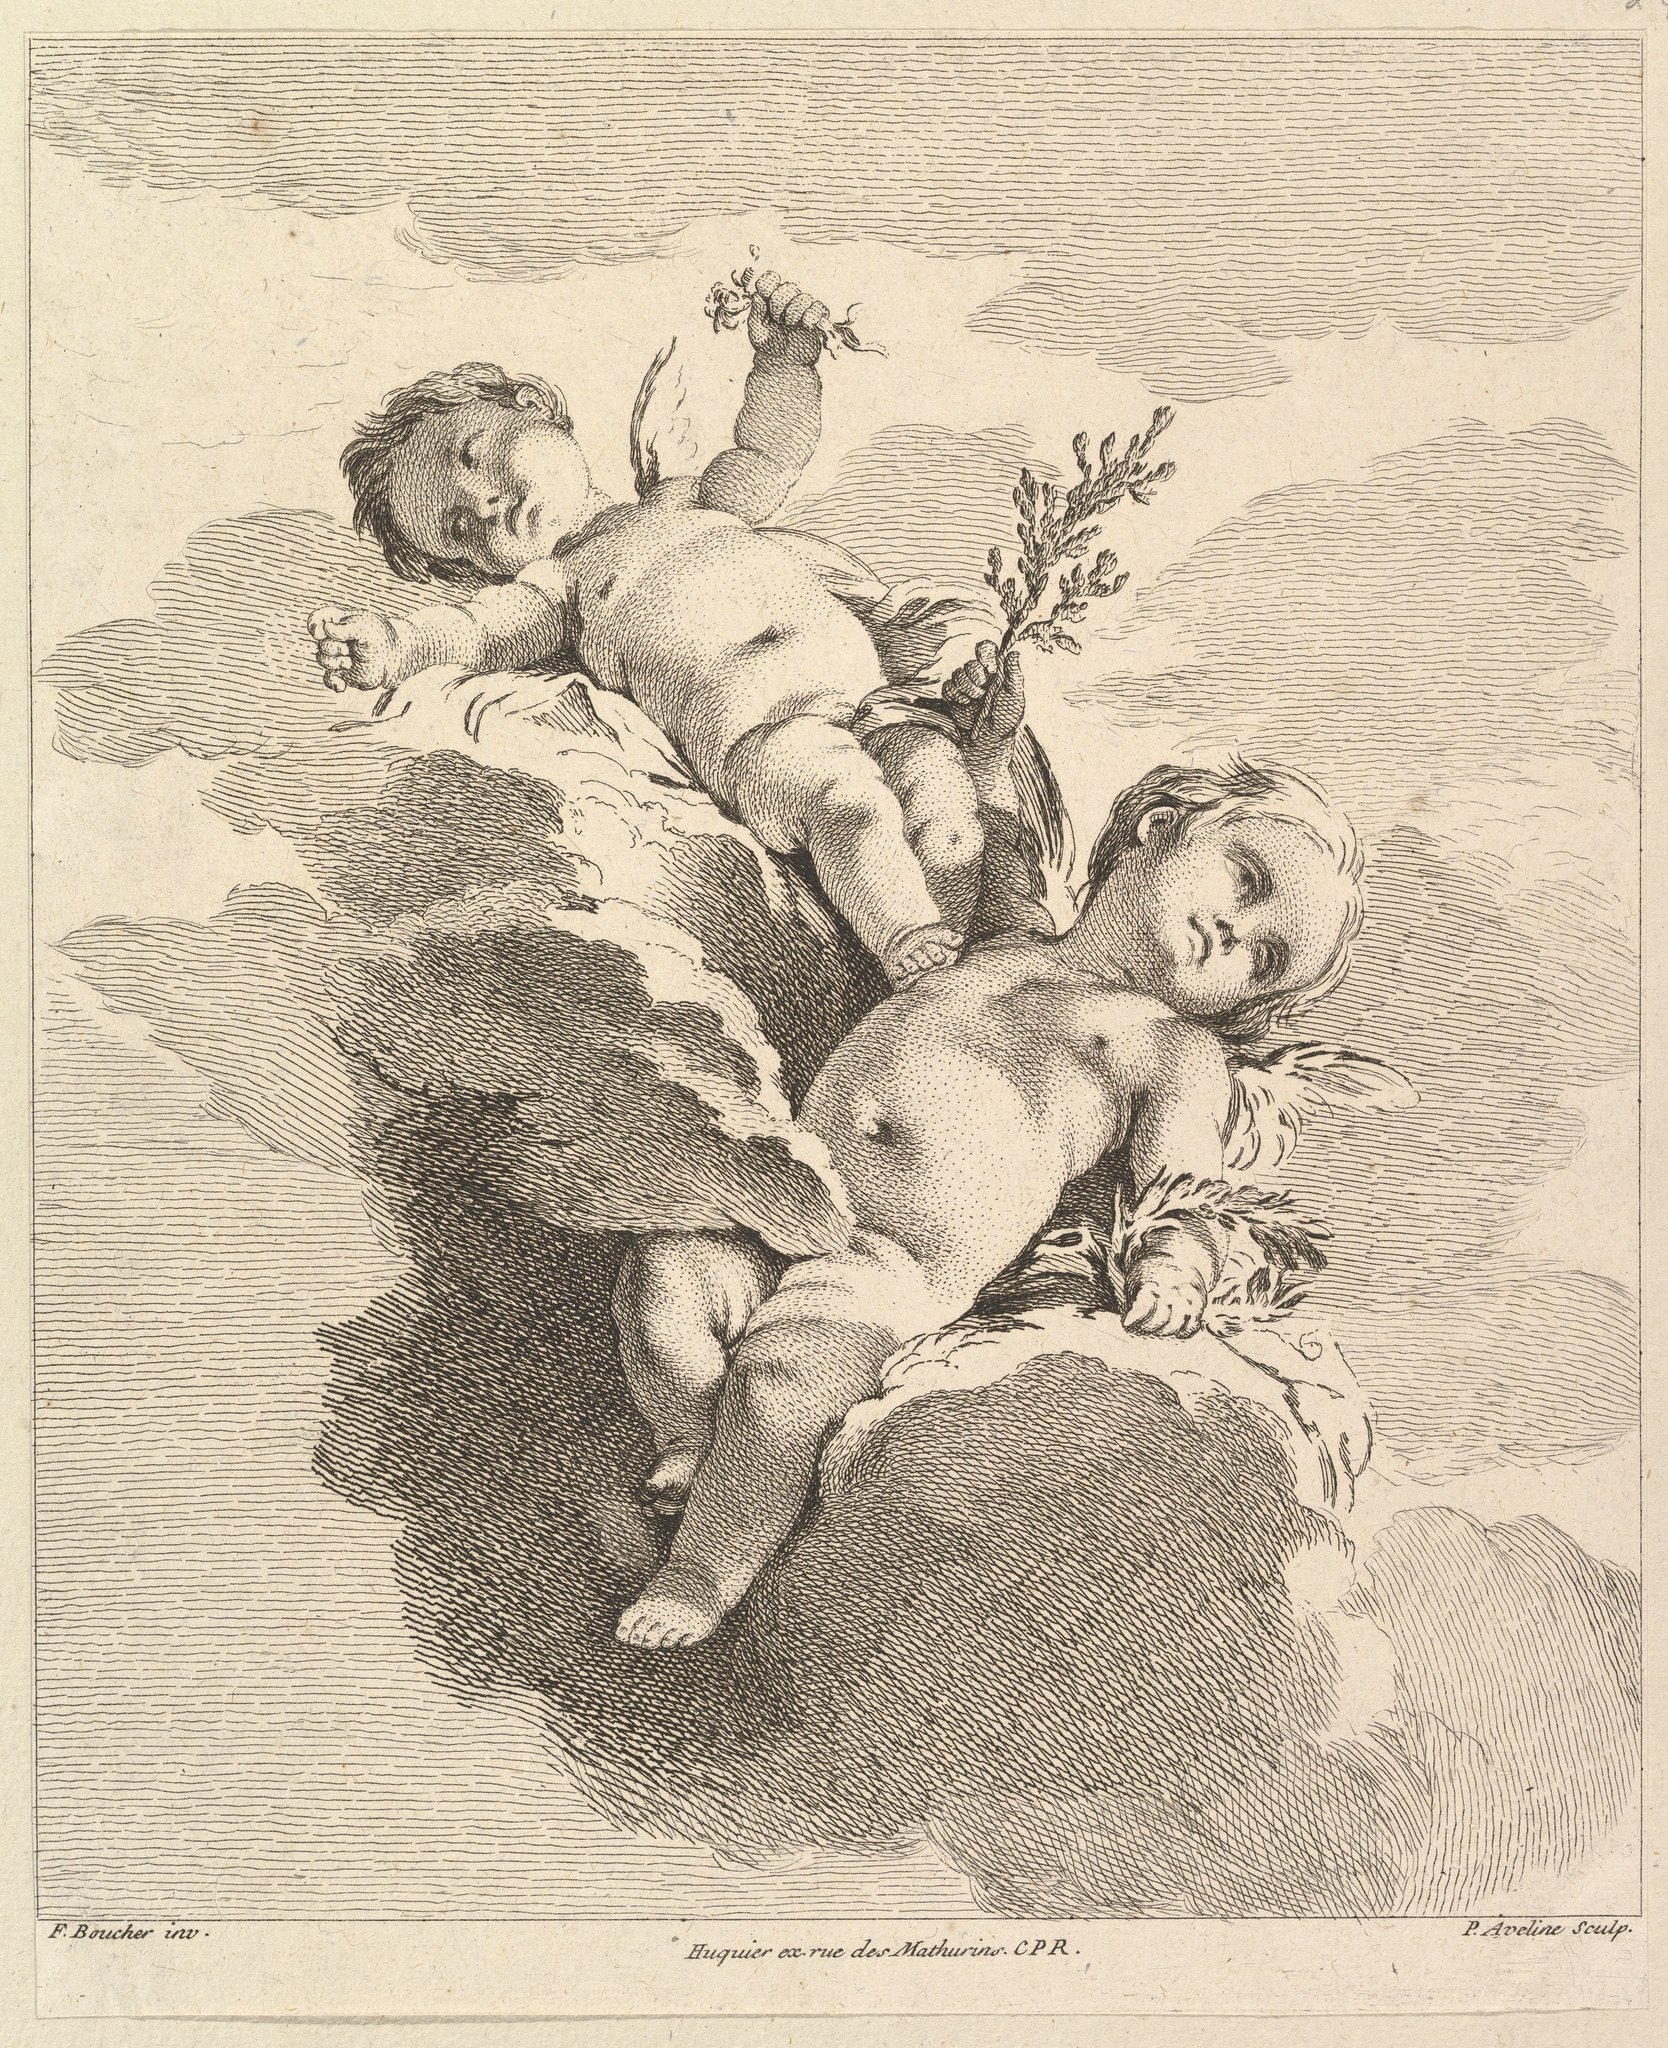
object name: print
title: Two Loves, one of which holds a crown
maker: pierre alexandre aveline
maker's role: artist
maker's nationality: french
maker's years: 1702-1760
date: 1727-1760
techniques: engraving, etching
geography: france